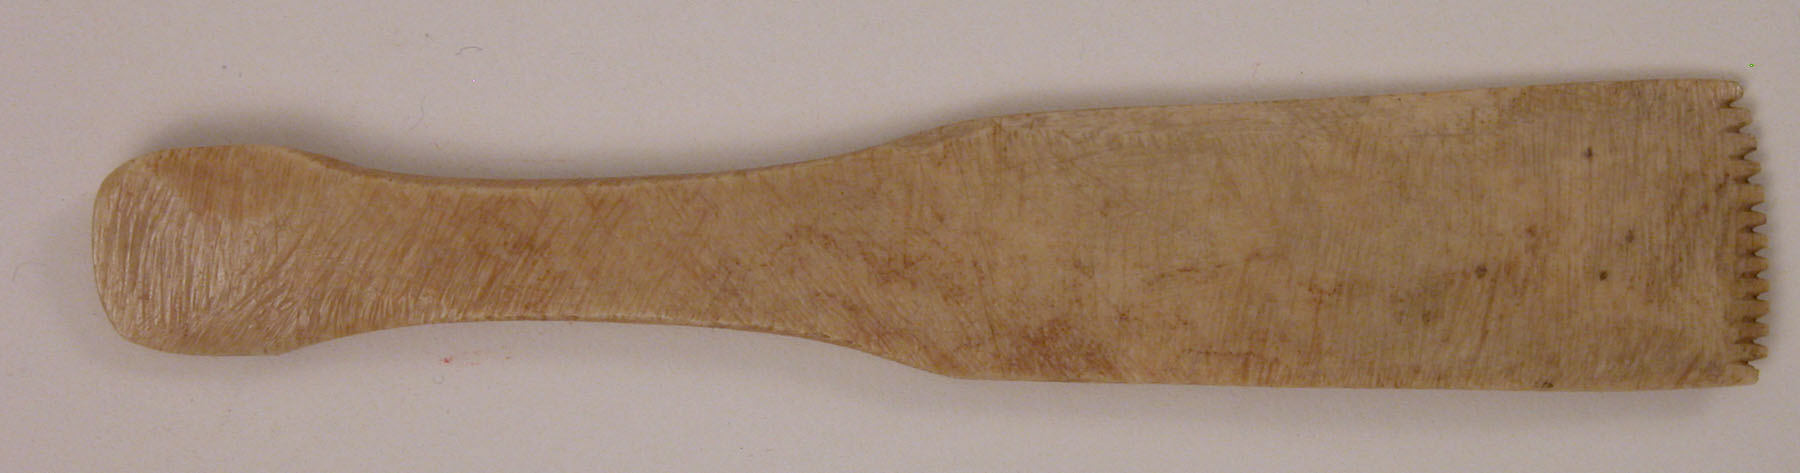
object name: loom or carding tool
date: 901-1500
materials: bone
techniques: incising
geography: egypt